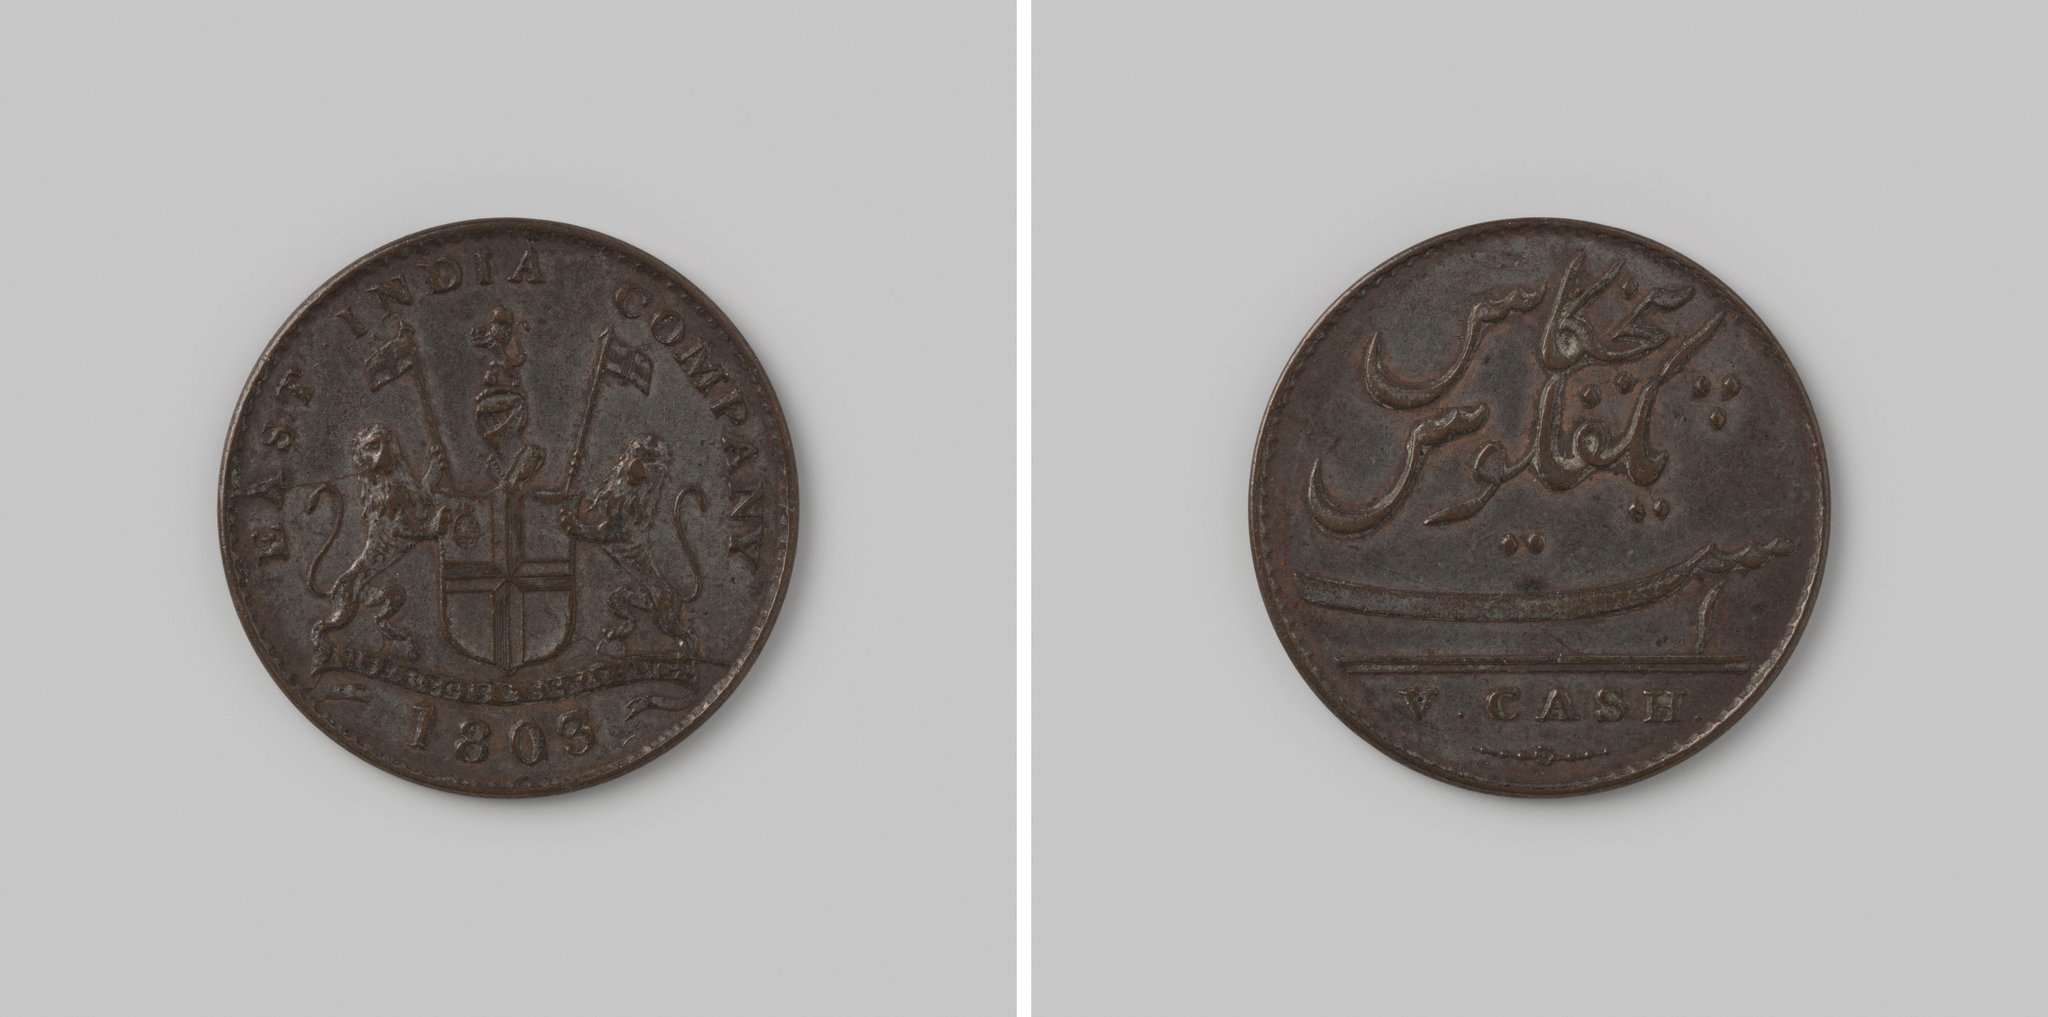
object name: coin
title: 5 cash voor Madras in India van de Engelse Oostindische Compagnie (EIC), 1803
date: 1803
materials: copper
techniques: striking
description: Verzilverde koperen munt. Voorzijde: door twee op banderol, waarin opschrift, staande leeuwen met pijl, waaraan vlag, in de klauw, gehouden wapenschild van de EIC, waarboven helmteken. Jaartal onderaan. Keerzijde: Bovenaan in drie regels waarde-aanduiding in Arabische lettertekens. In afsnede waarde-aanduiding in het Engels: V. Cash. Gladde rand. Geslagen in Engeland als proef.